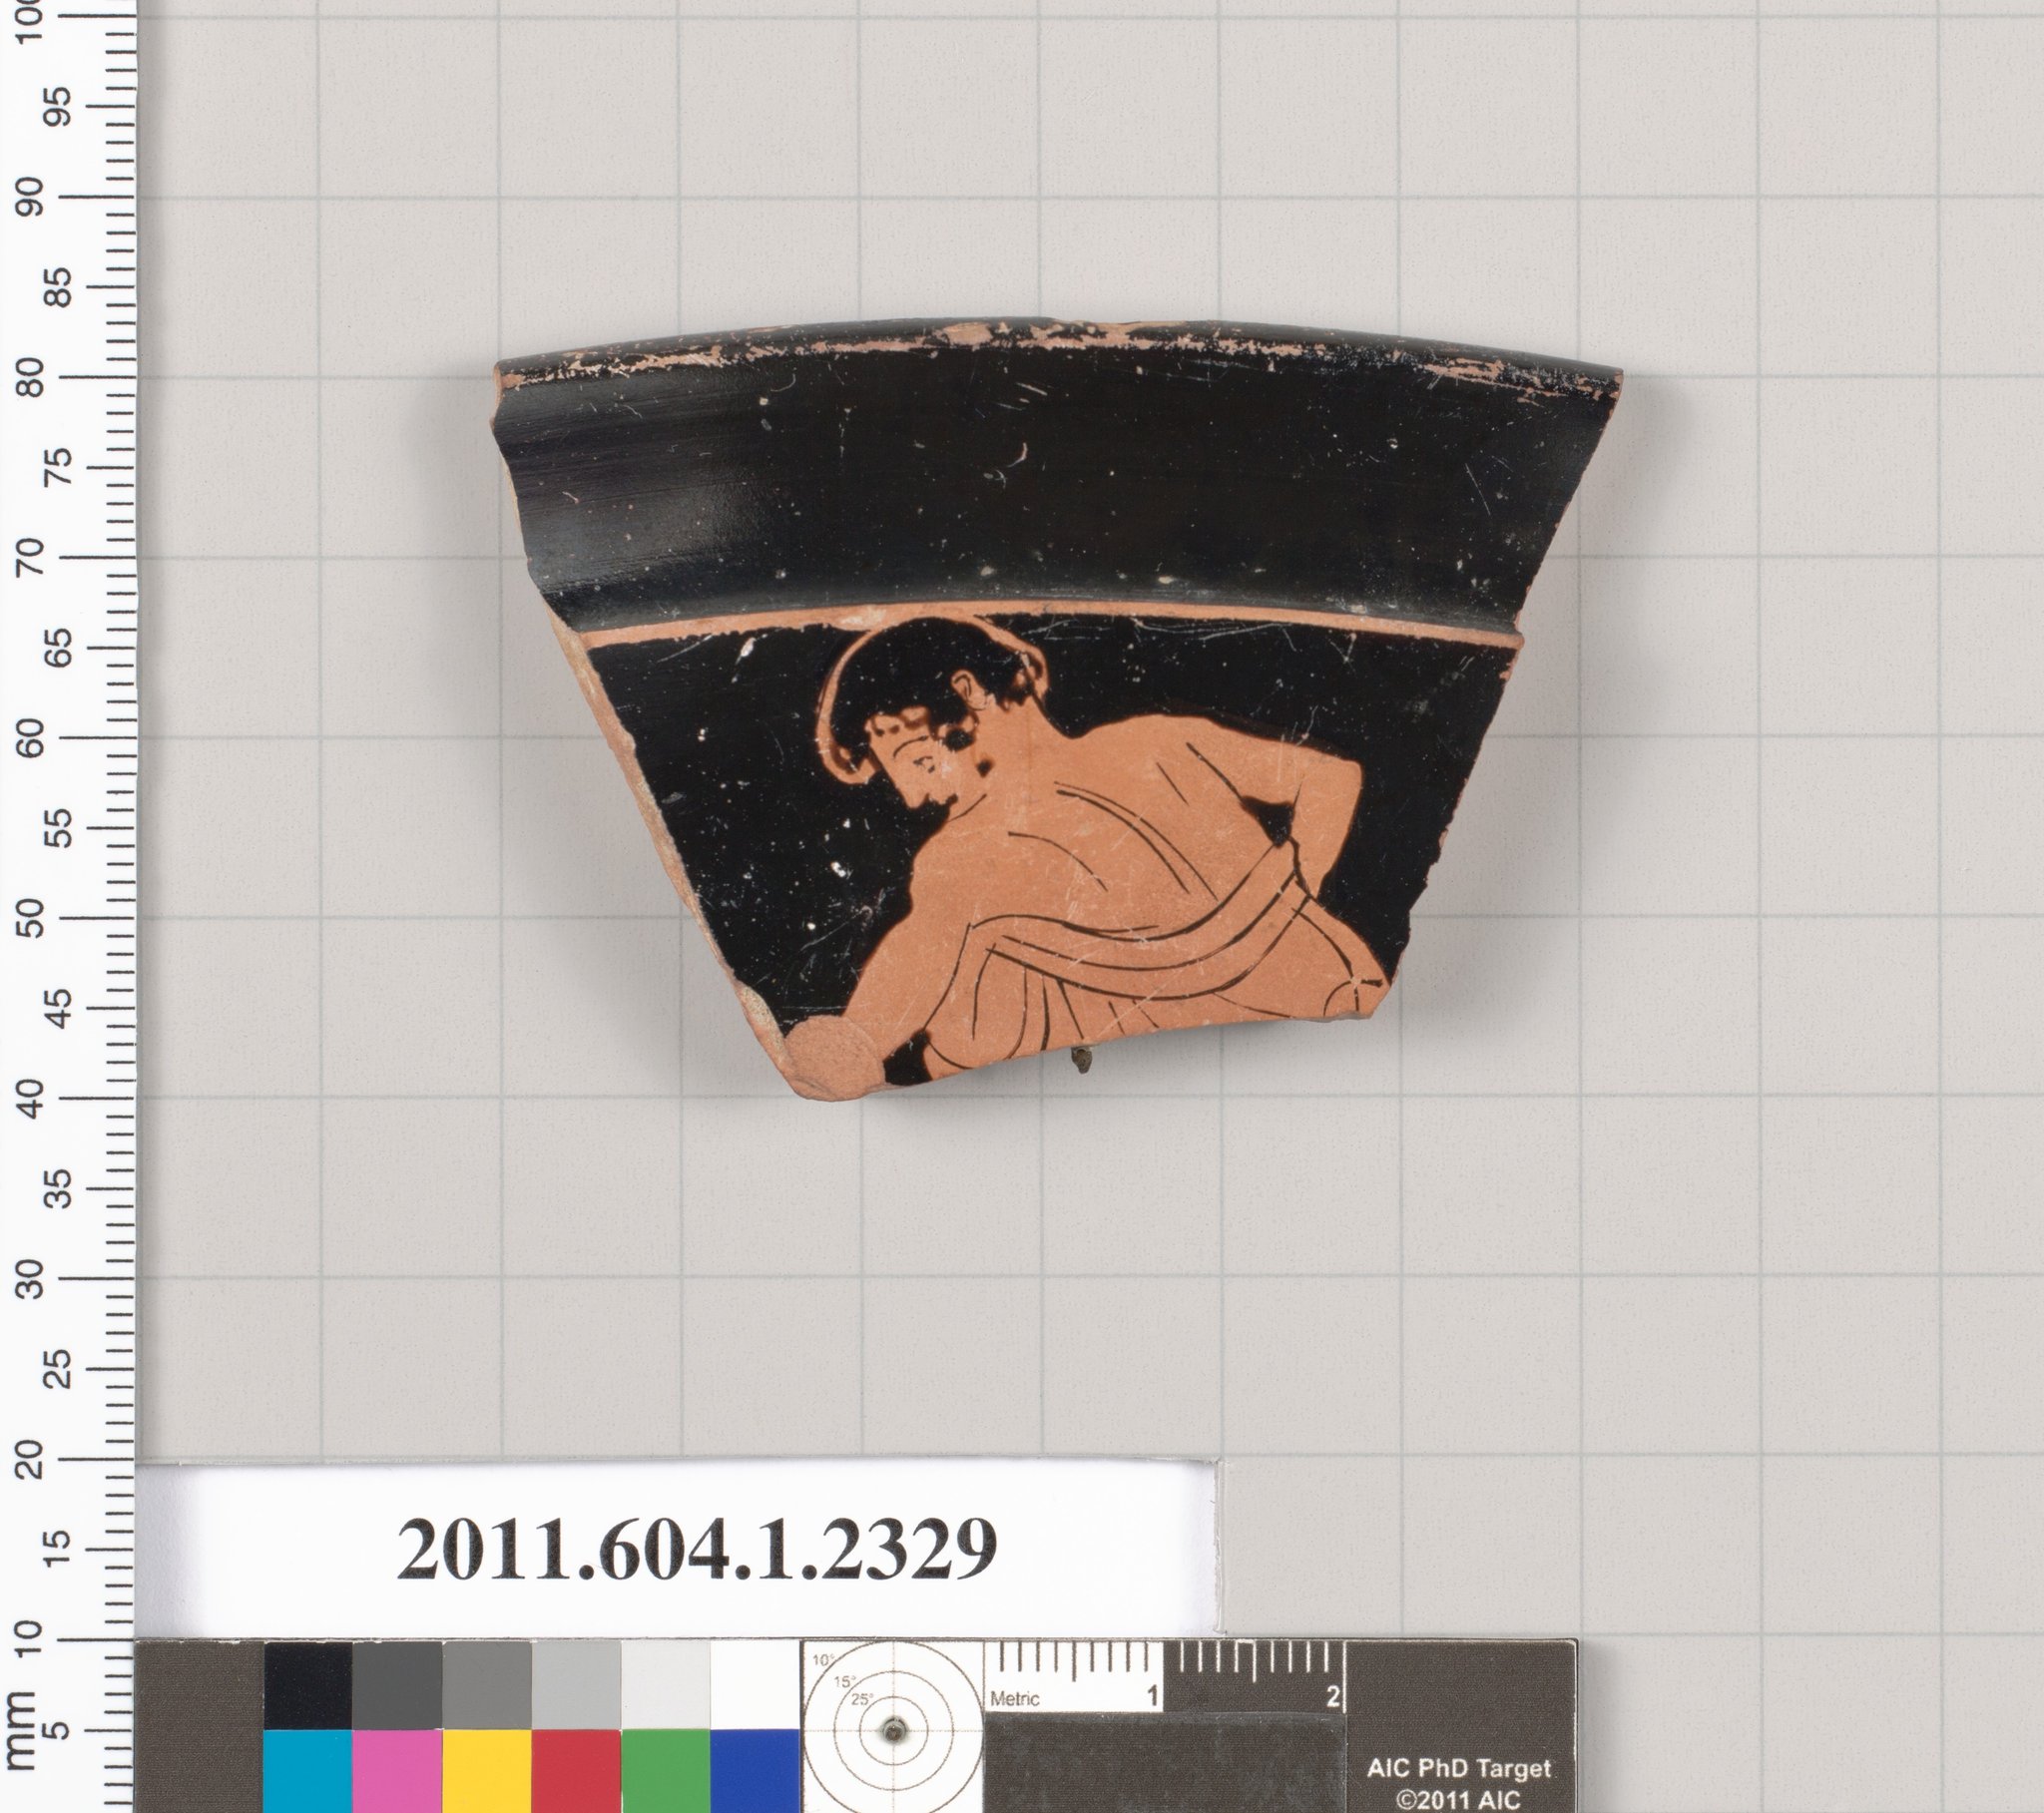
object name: kylix fragment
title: Terracotta rim fragment of a kylix (drinking cup)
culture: greek, attic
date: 460-450 BCE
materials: terracotta